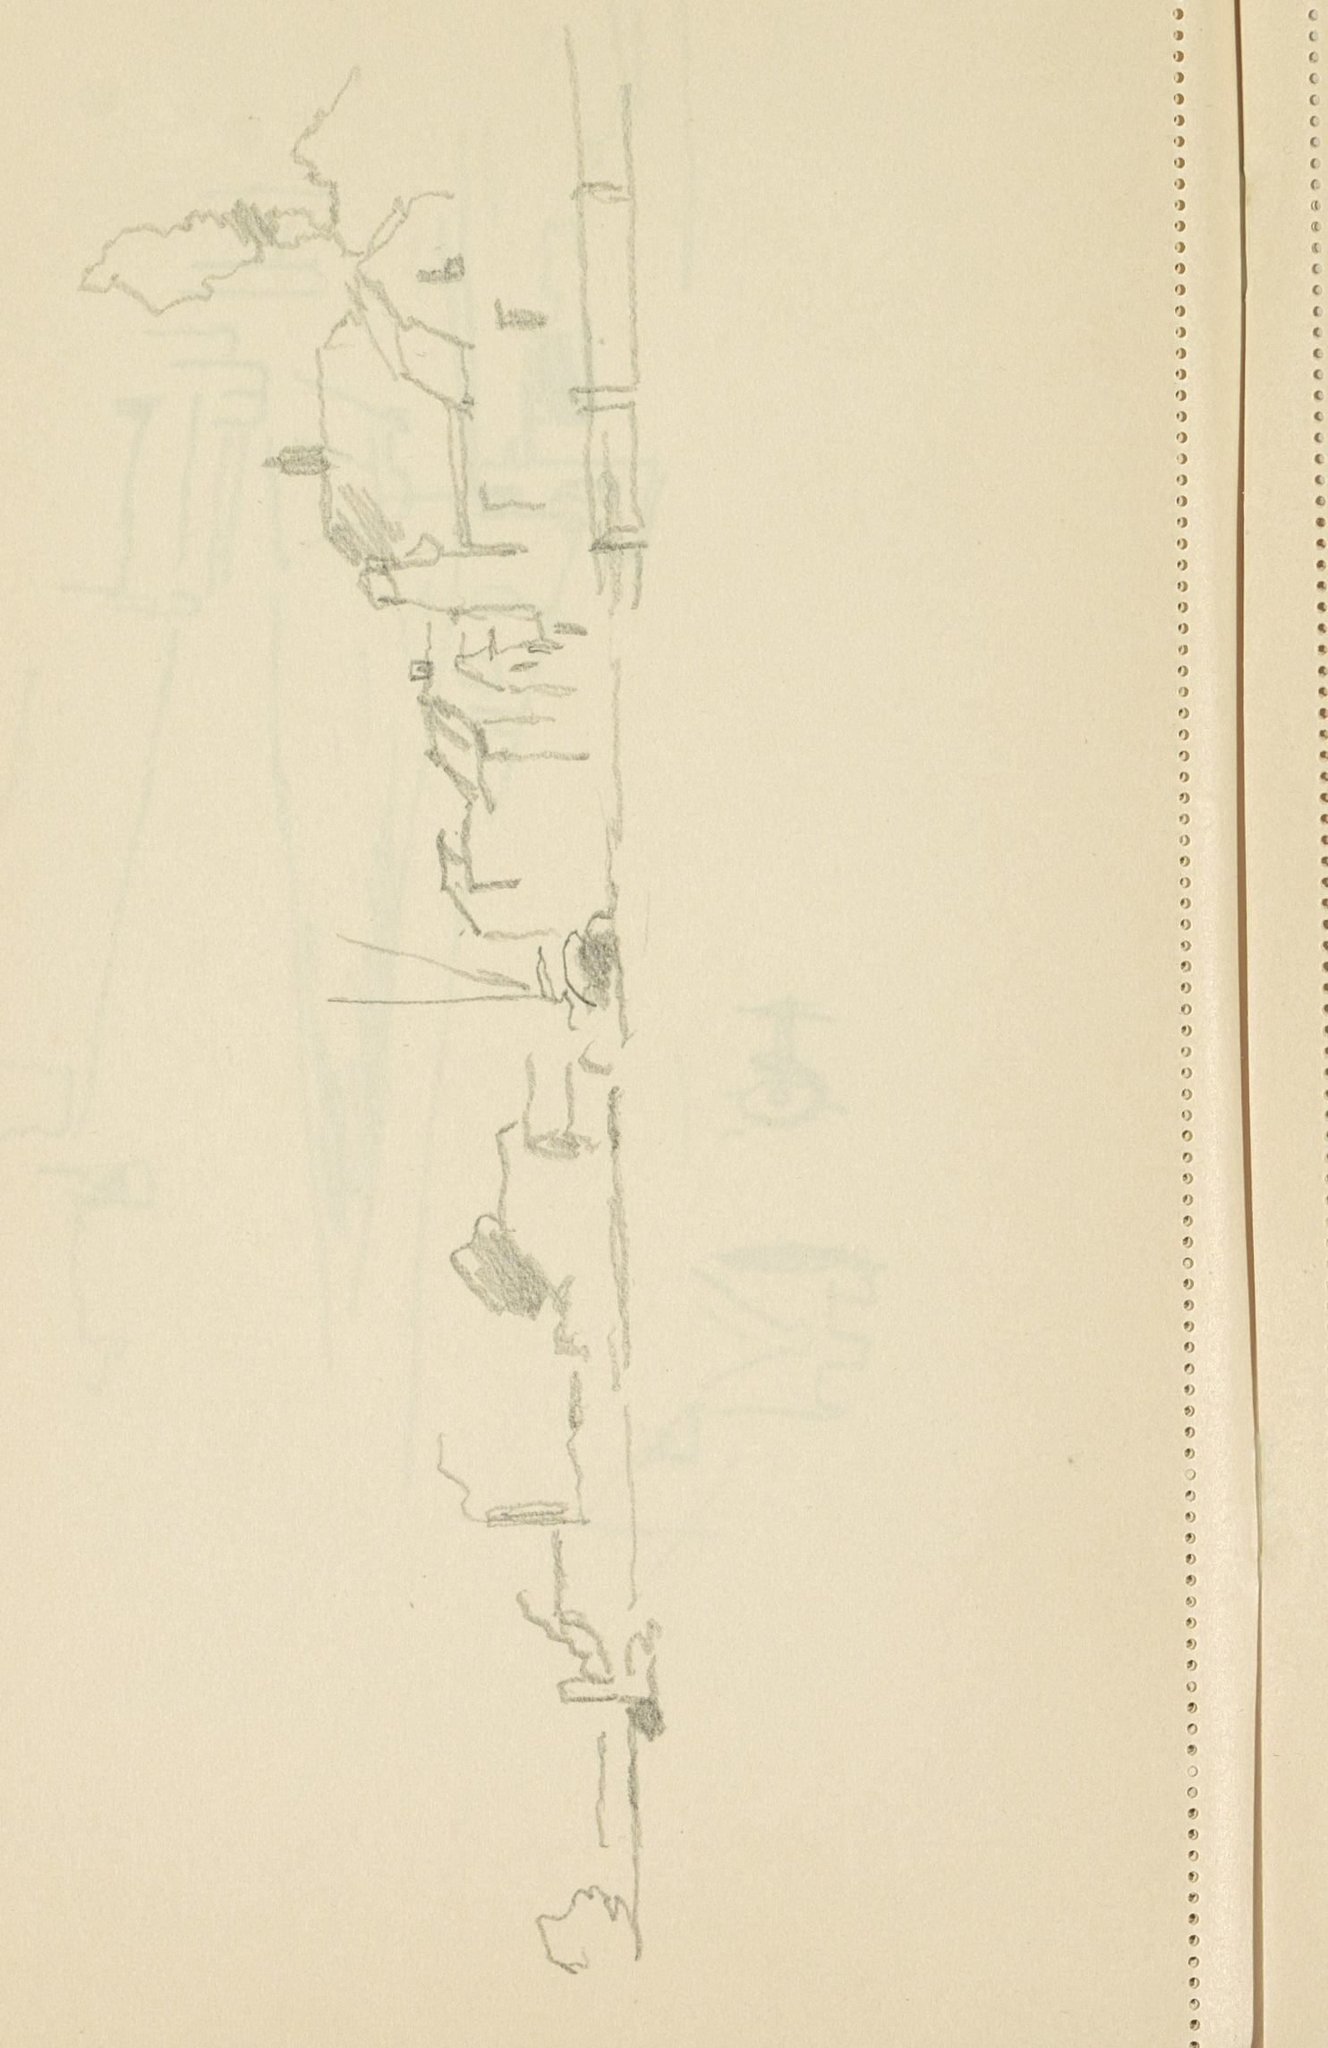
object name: sketchbook leaf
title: Gezicht op een stad of dorp aan het water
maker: cornelis vreedenburgh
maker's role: draughtsman, print maker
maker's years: 1880-1946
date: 1890-1946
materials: paper, pencil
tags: city-view, and landscape with man-made constructions, landscapes with waters, waterscapes, seascapes (in the temperate zone)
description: Blad 57 verso uit een schetsboek met 73 bladen.